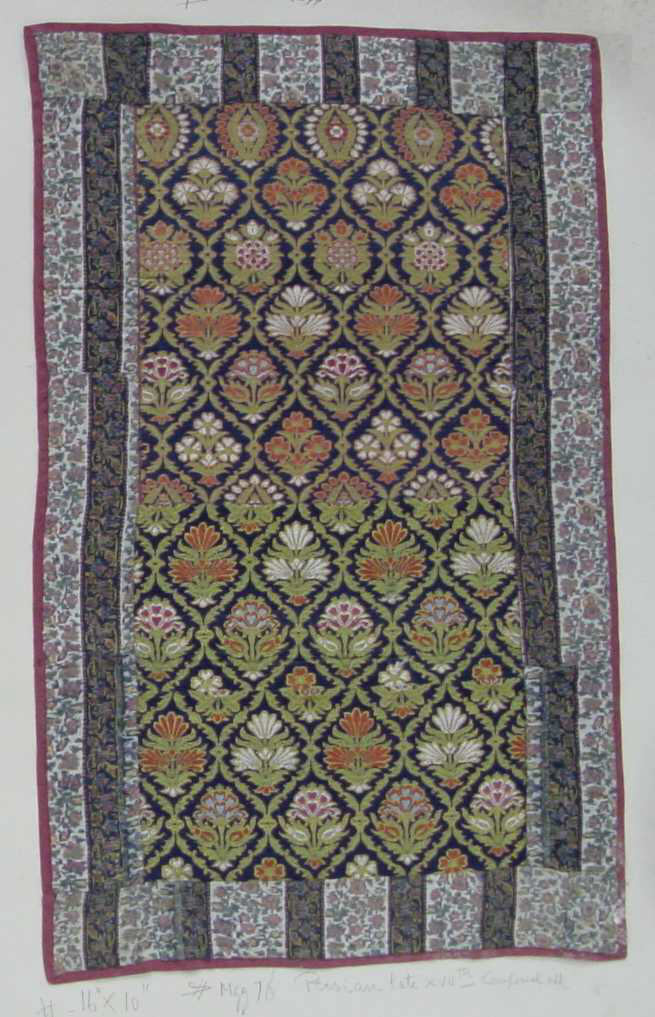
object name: textile fragment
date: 1667-1700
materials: silk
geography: iran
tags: flowers